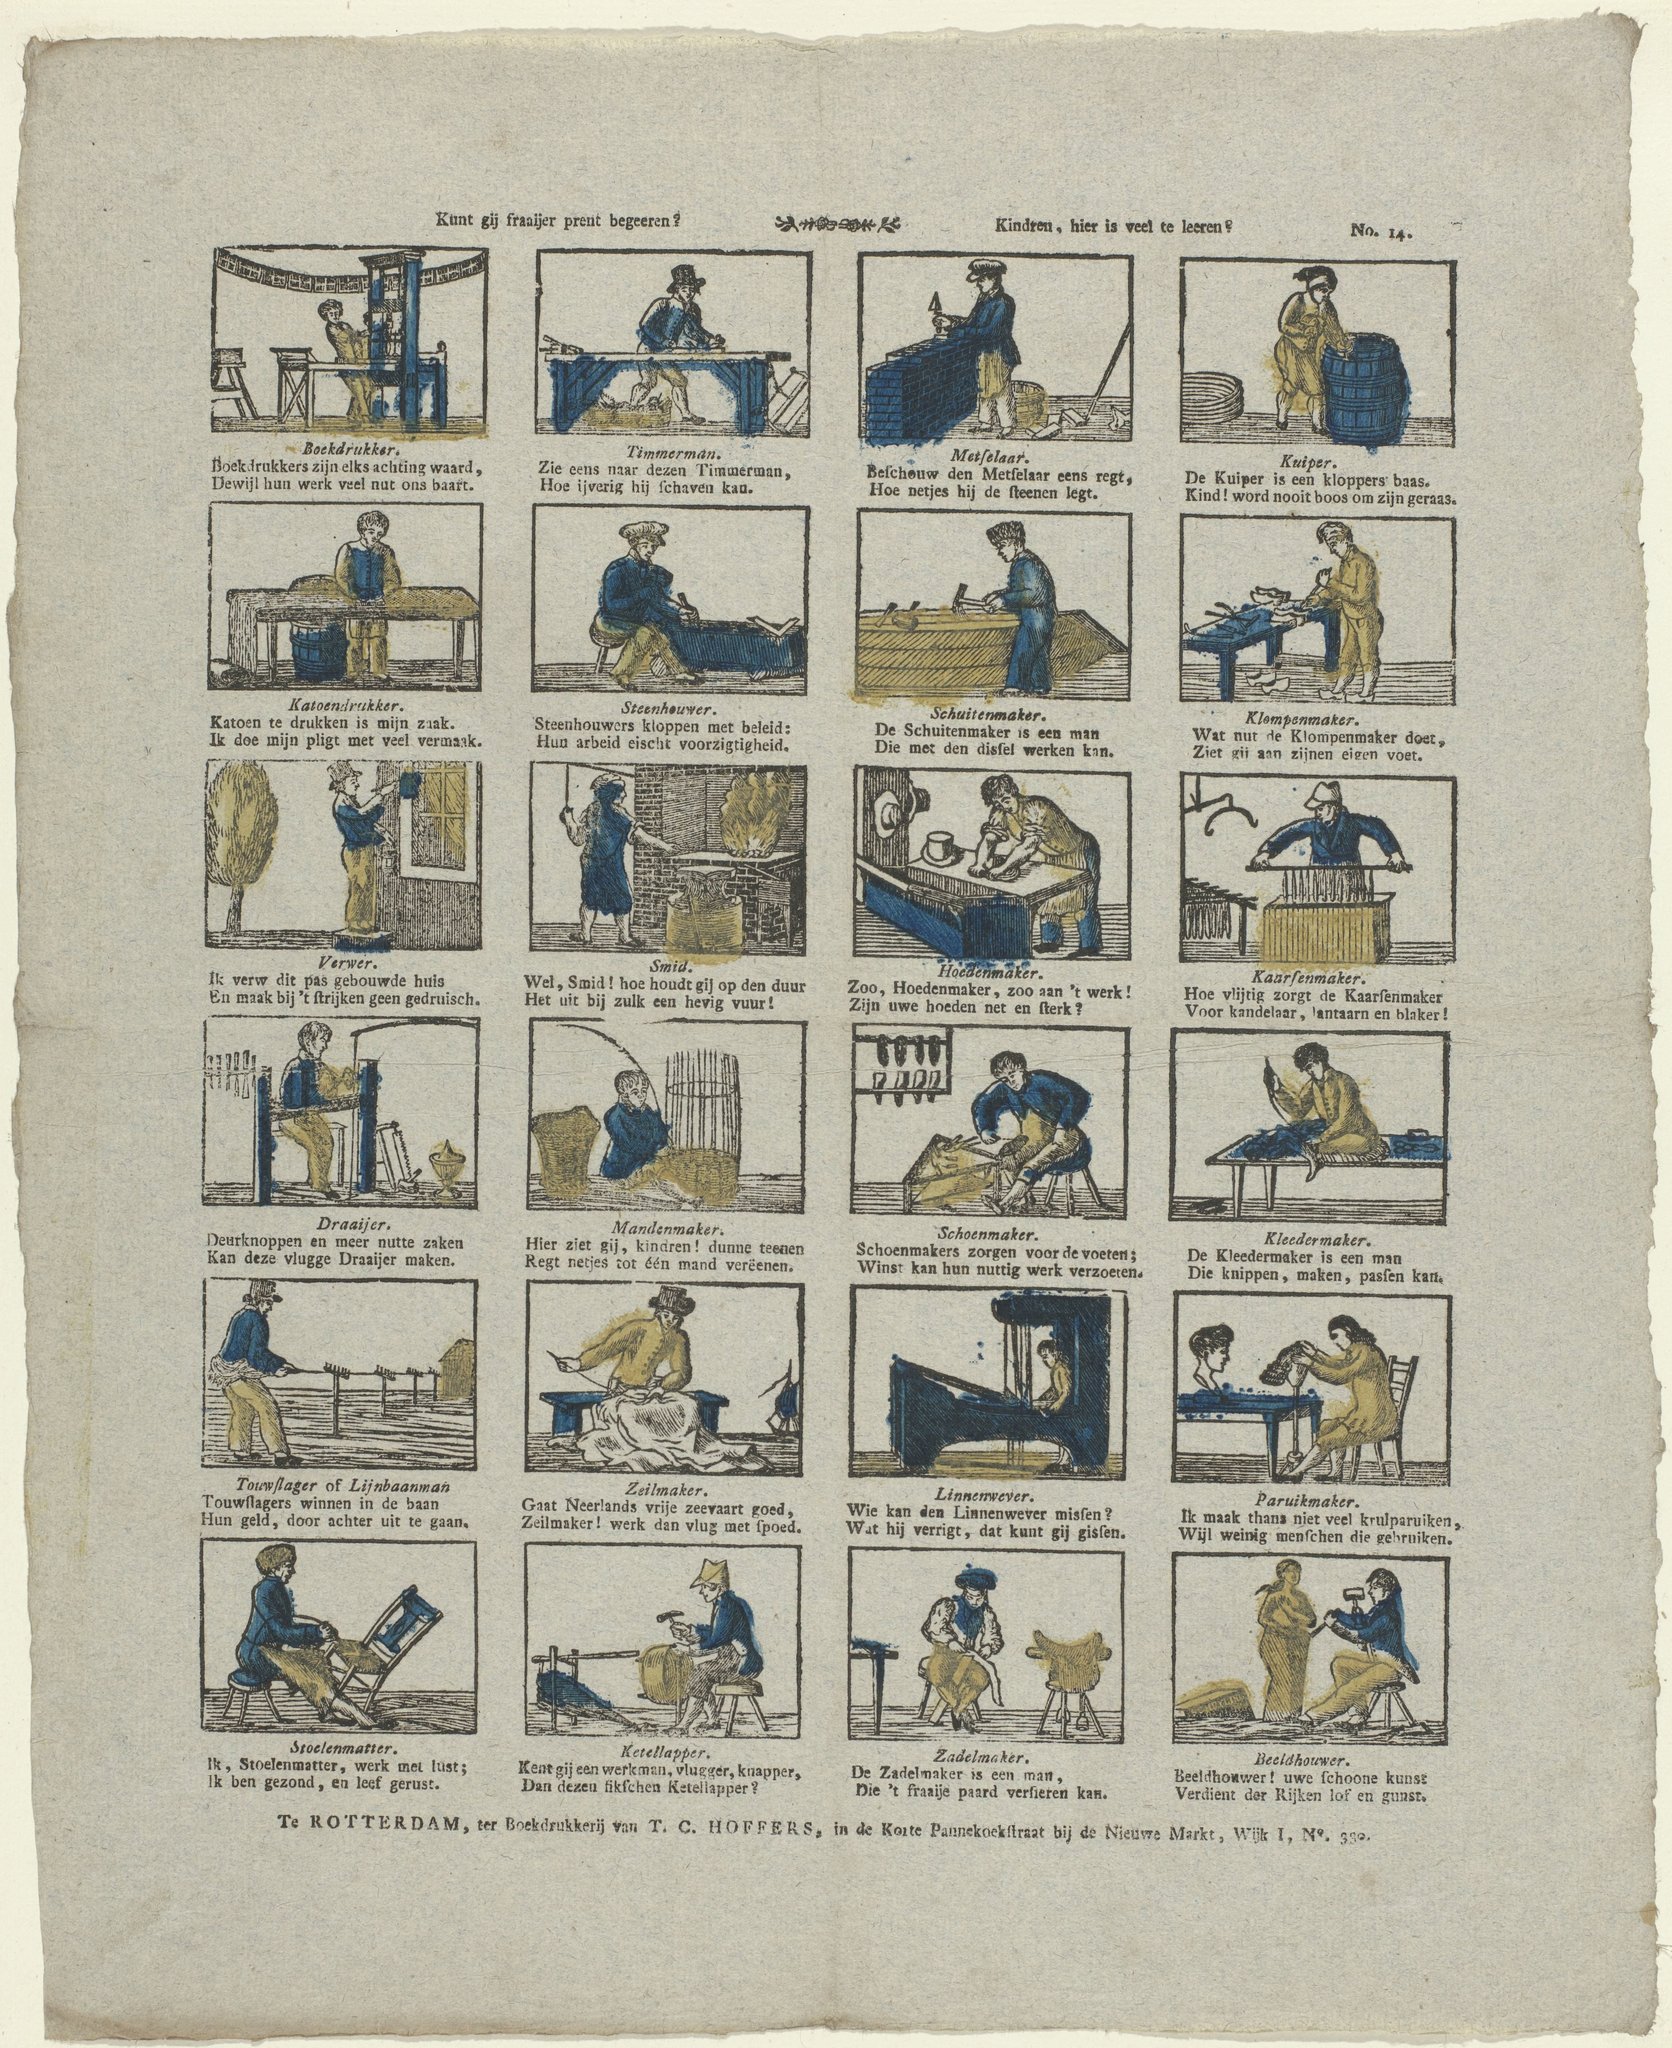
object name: popular print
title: Kunt gij fraaijer prent begeeren? / Kindren, hier is veel te leeren?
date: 1820-1848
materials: paper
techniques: colour, letterpress printing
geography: rotterdam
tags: carpenter, craft-production, skilled handiwork, crafts and industries, tapestry weaver, gobelin maker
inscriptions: collector's mark: Lugt 2760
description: Blad met 24 voorstellingen van ambachtslieden en beroepen, zoals timmerman, hoedenmaker en linnenwever. Onder elke afbeelding een tweeregelig vers. Genummerd rechtsboven: No. 14.